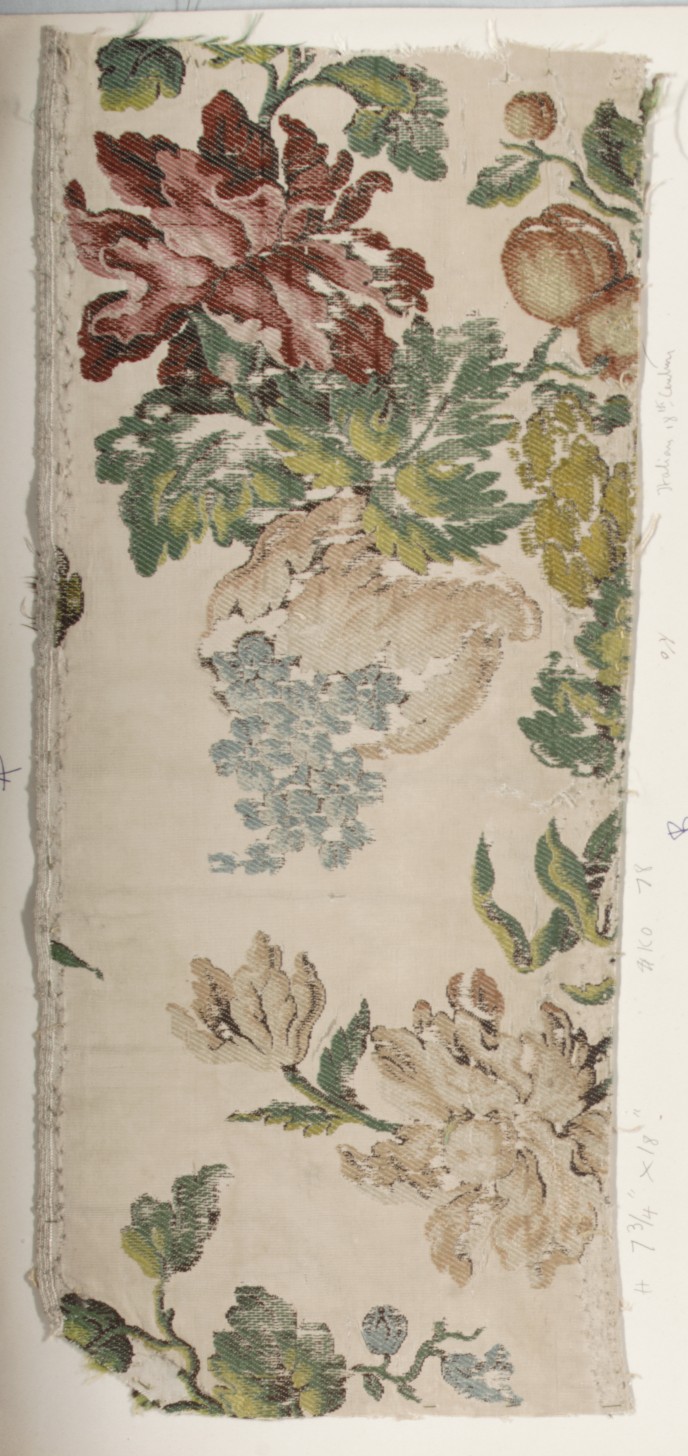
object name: fragment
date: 1701-1800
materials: silk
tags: flowers,leaves